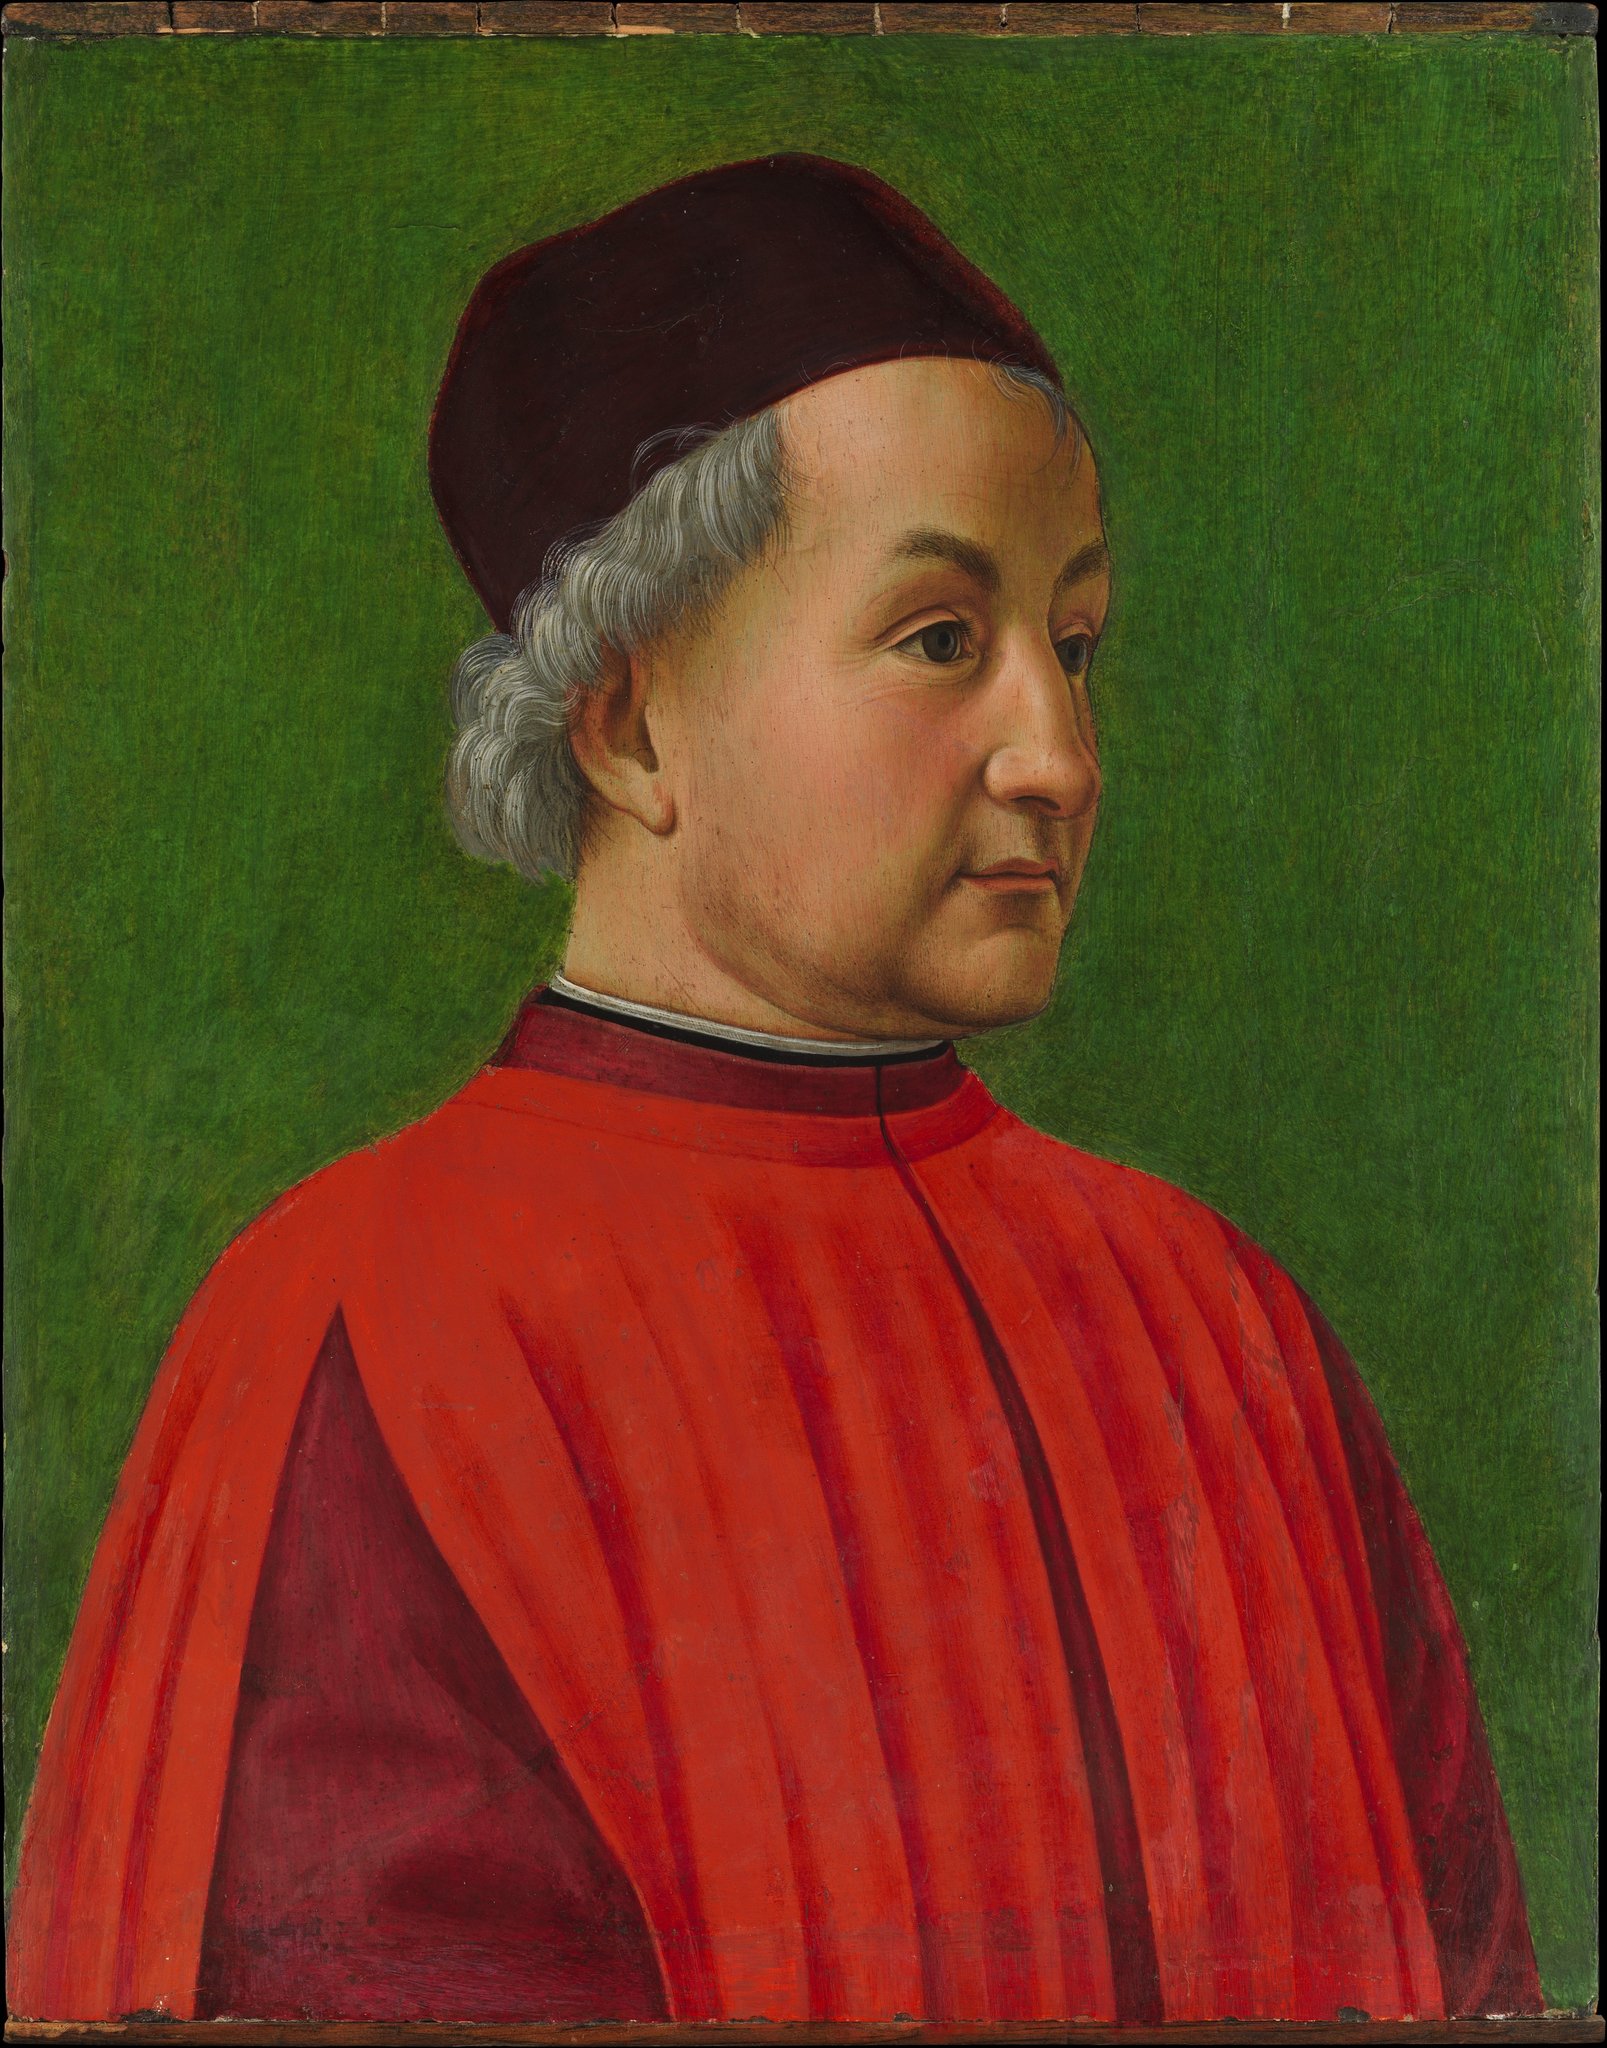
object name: painting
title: Portrait of a Man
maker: domenico ghirlandaio (domenico bigordi)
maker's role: artist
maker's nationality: italian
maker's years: 1448-1494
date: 1469-1494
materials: paint, wood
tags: men,portraits